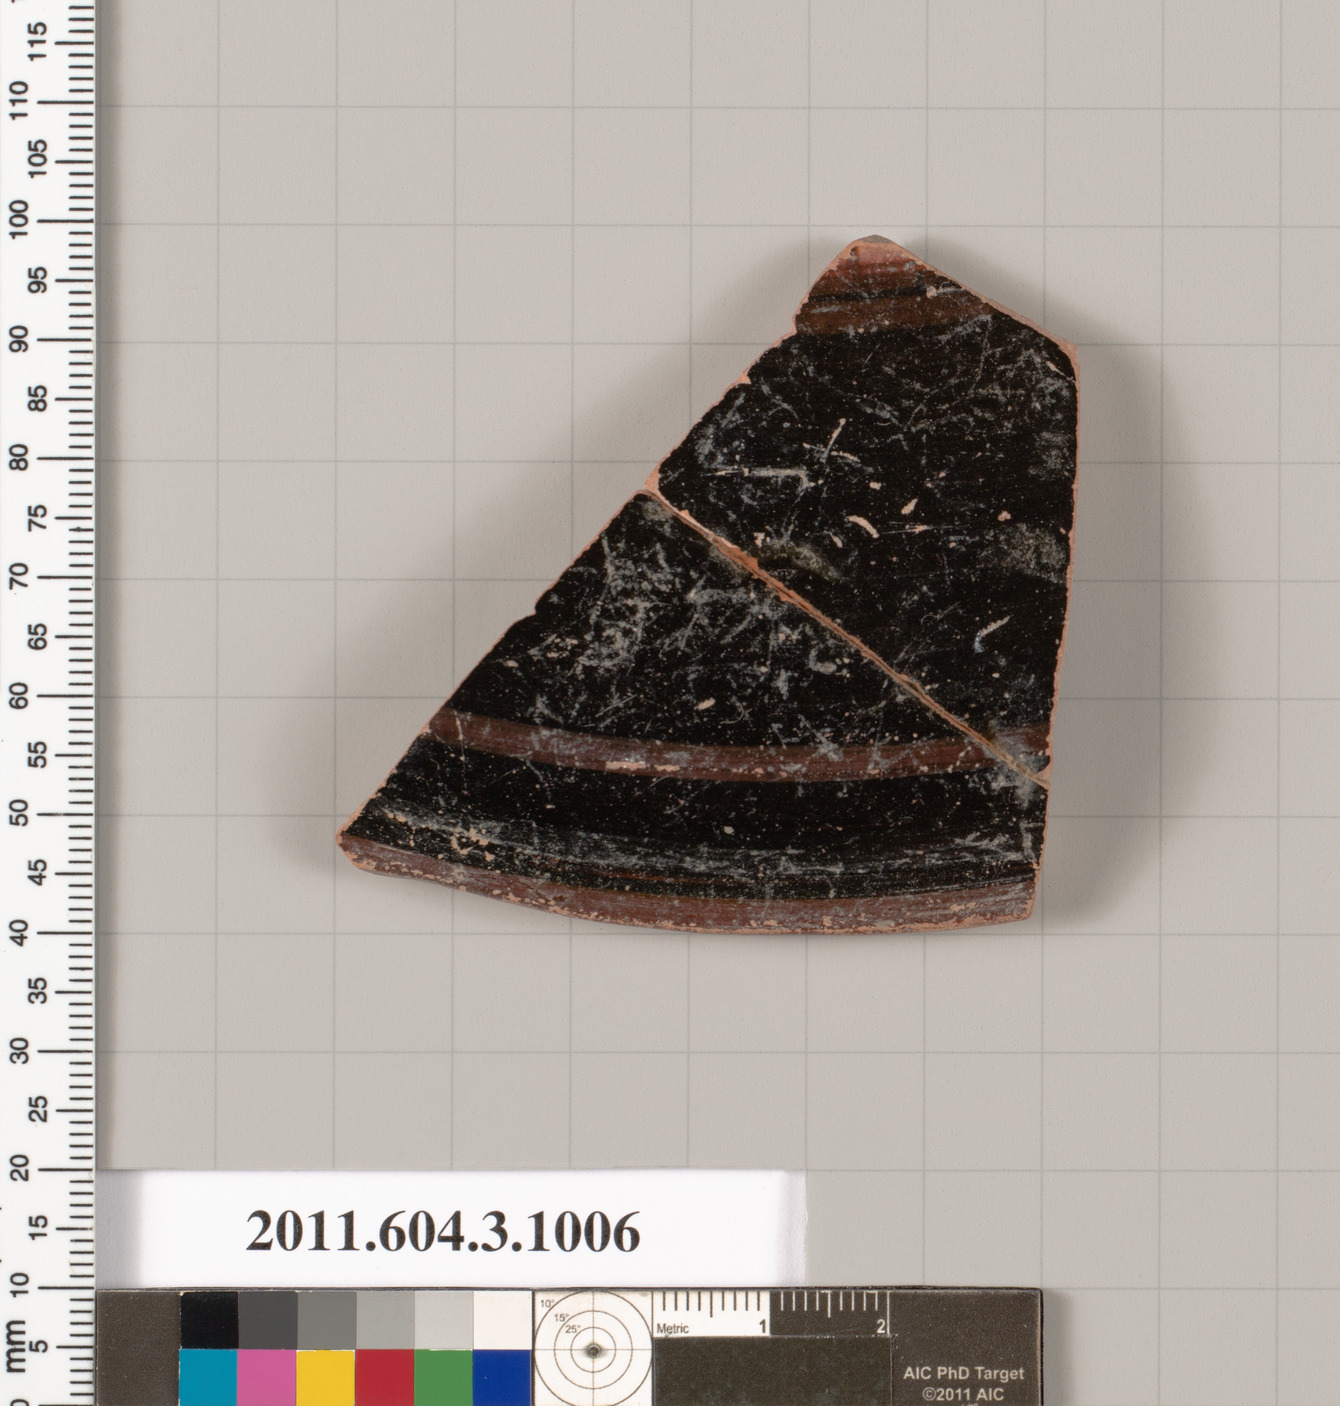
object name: lekanis lid fragment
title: Terracotta fragment of a lekanis lid (covered dish)?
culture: greek, attic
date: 600-501 BCE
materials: terracotta